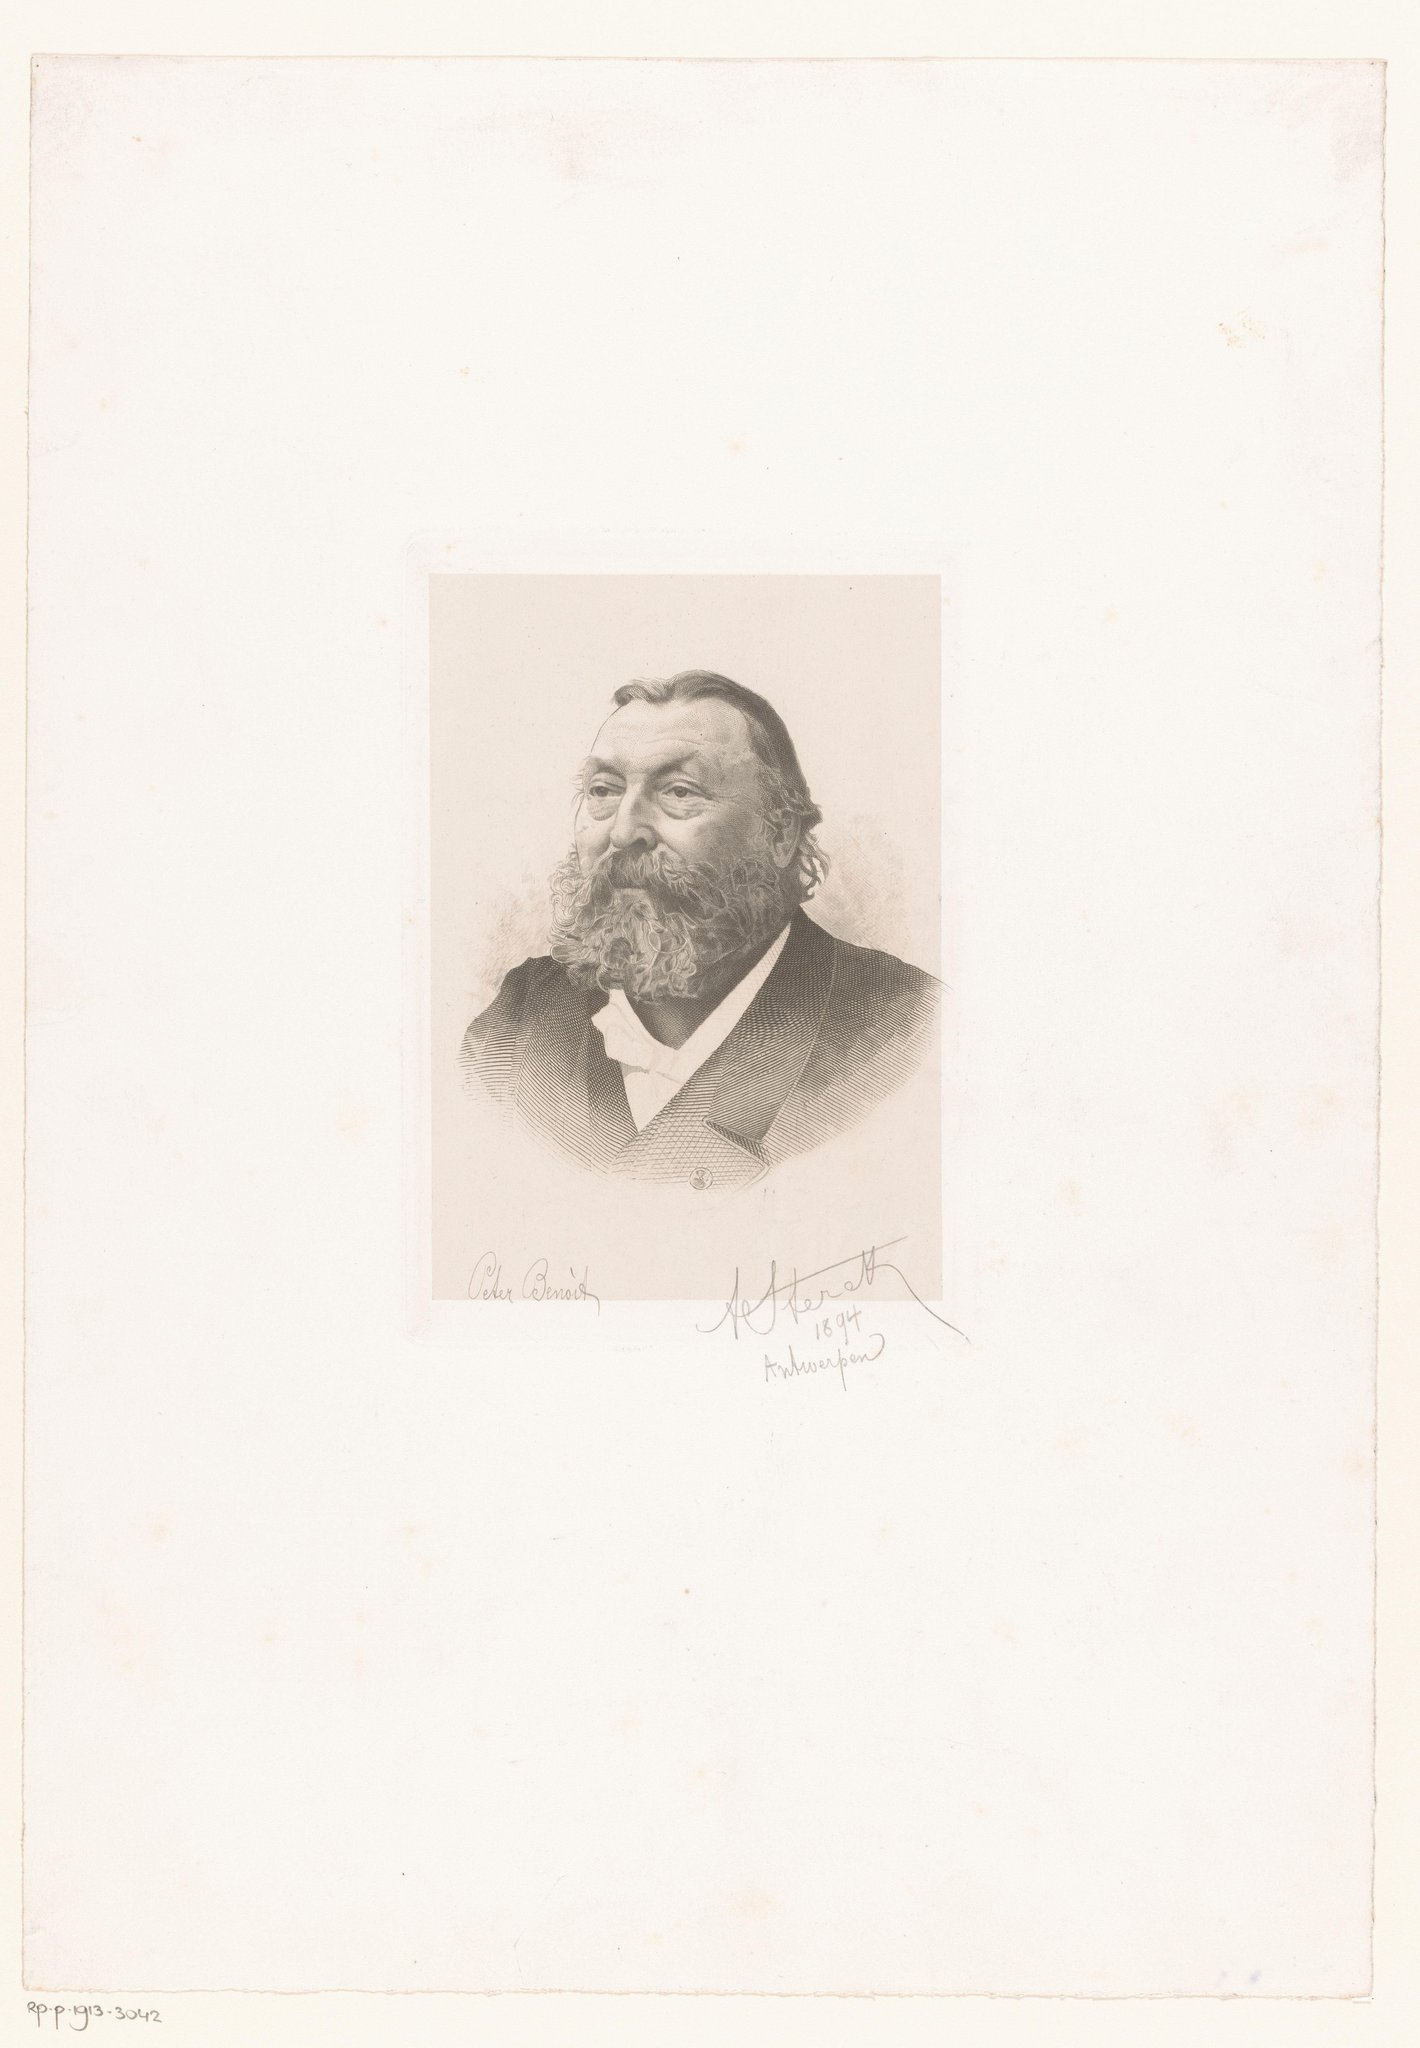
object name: print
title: Portret van Peter Benoît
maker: arthur sterck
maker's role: print maker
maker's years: 1868-1897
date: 1894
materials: paper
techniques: etching, roulette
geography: antwerp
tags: historical persons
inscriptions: collector's mark: Lugt 2228